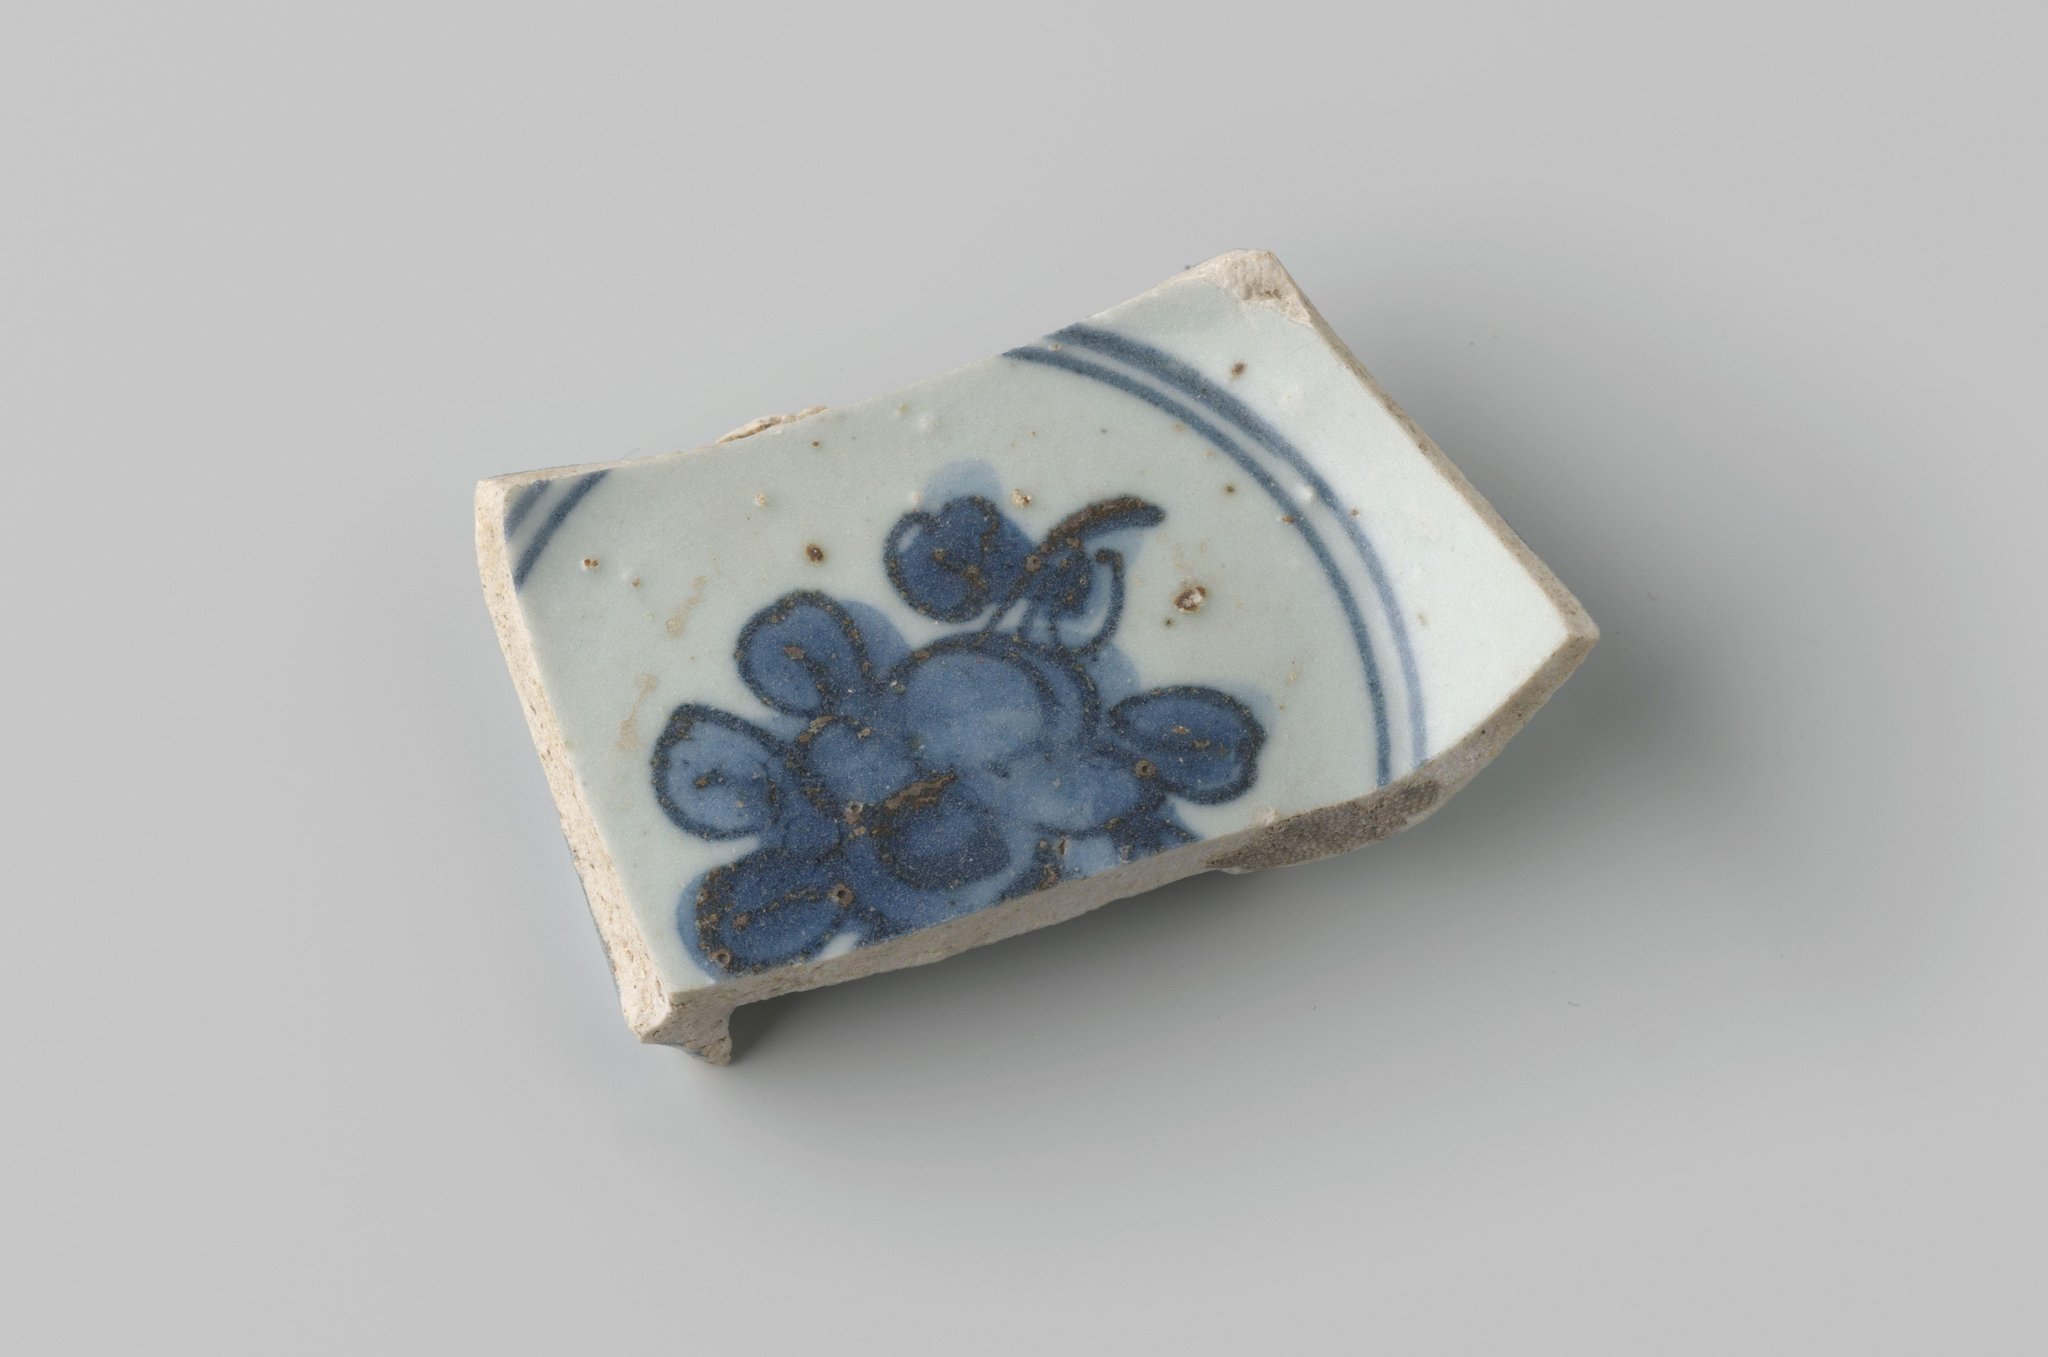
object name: sherd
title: Fragment kom uit V.O.C.-schip de 'Witte Leeuw'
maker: Anonymous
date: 1613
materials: porcelain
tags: verenigde oostindische compagnie, sint-helena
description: Bodemfragment kom uit V.O.C.-schip de 'Witte Leeuw'.